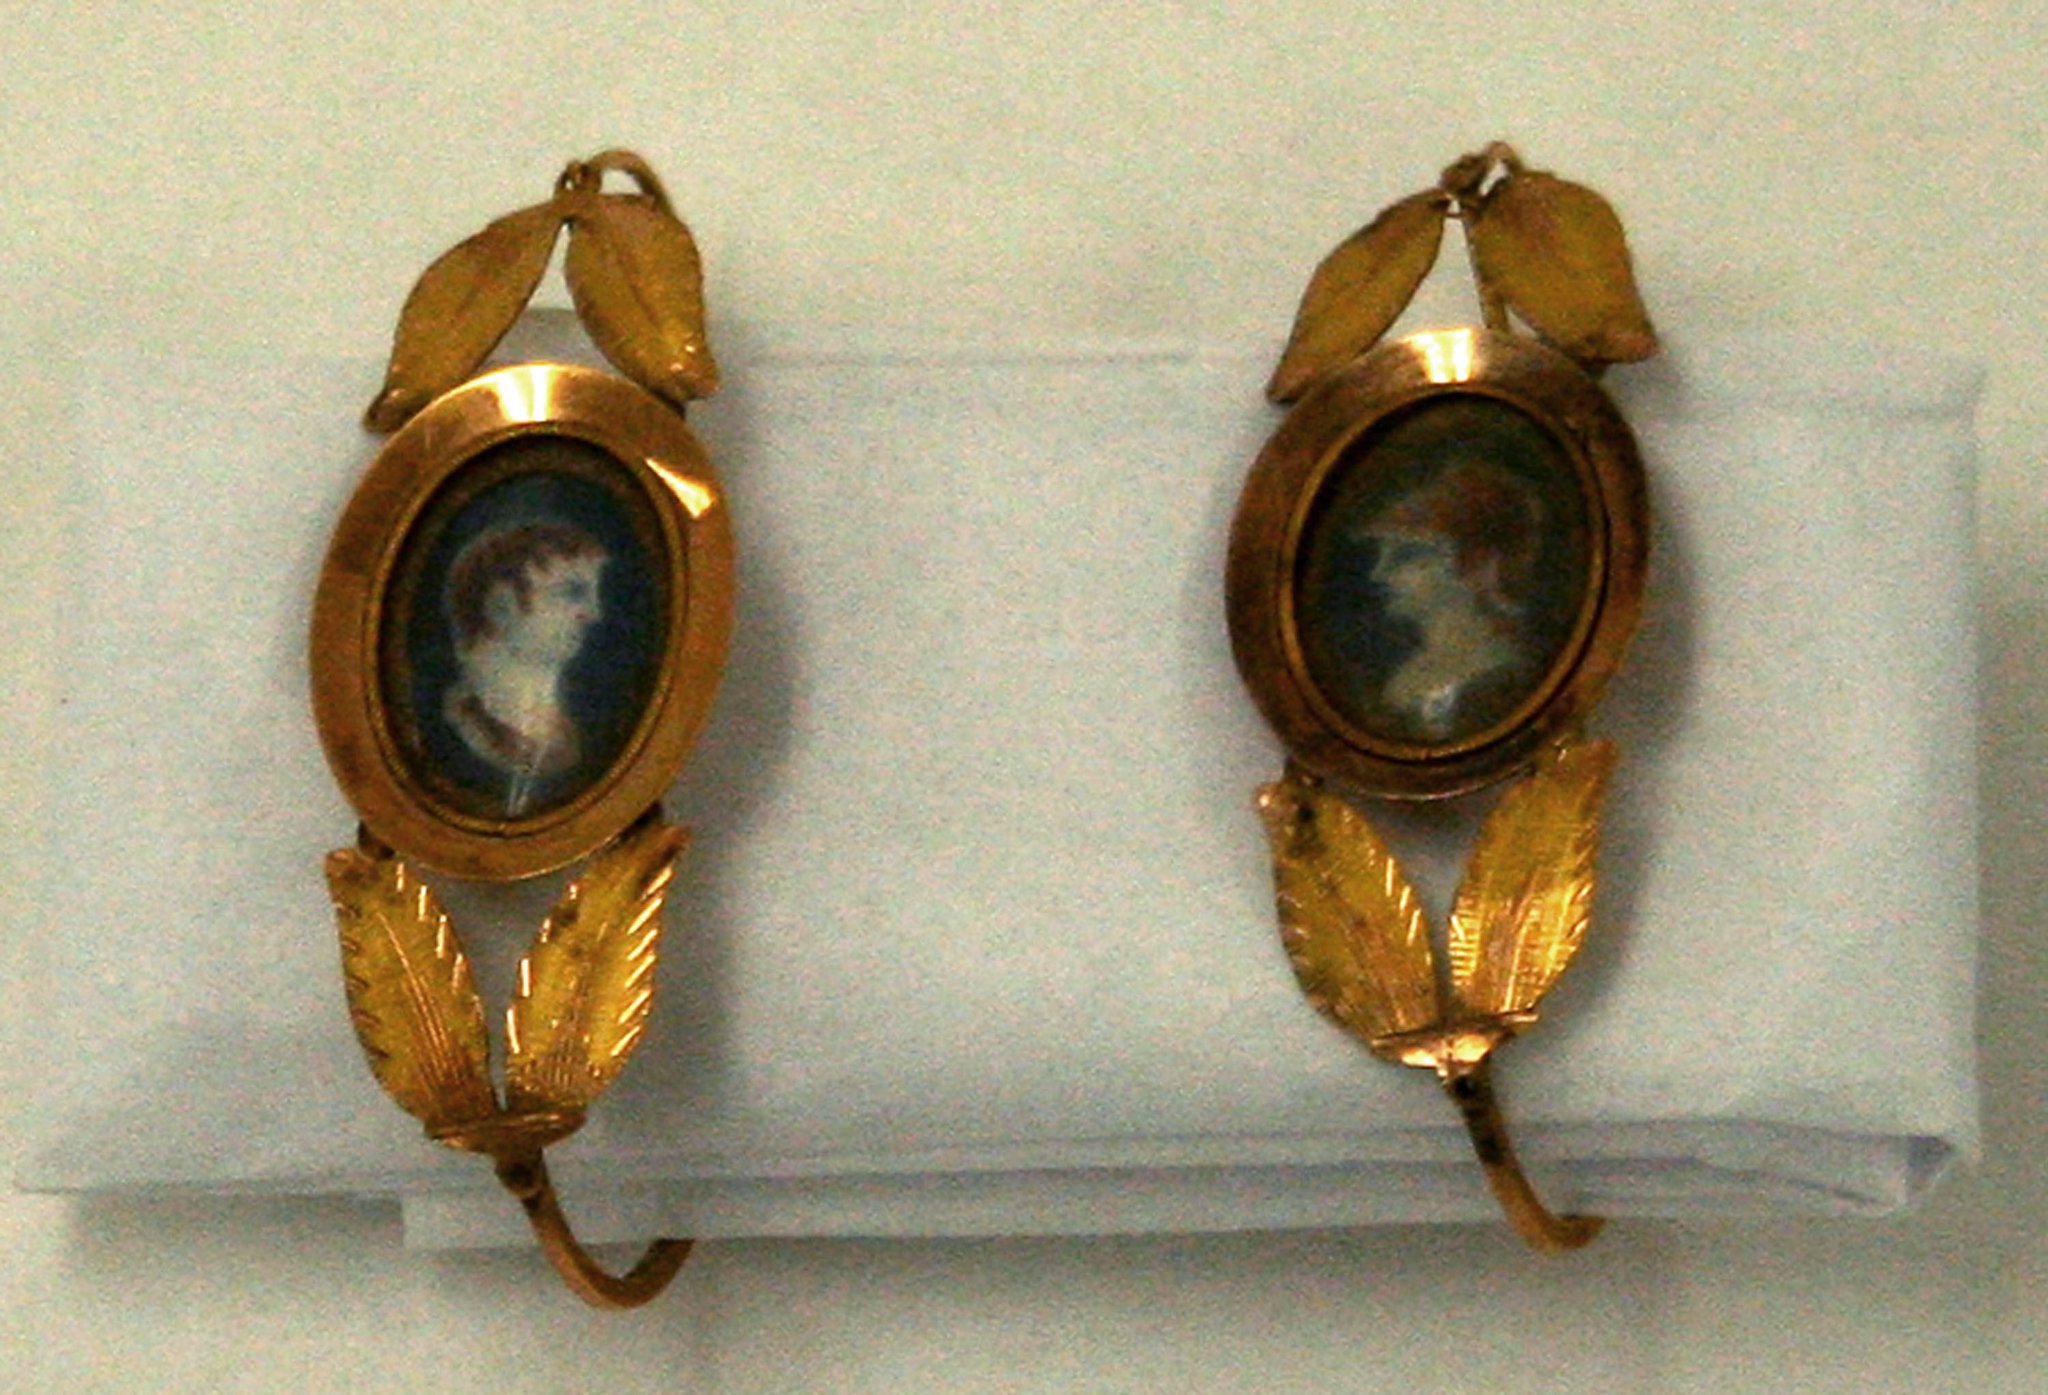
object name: earring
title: Earrings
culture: french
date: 1804-1809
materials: gold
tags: men,profiles,women